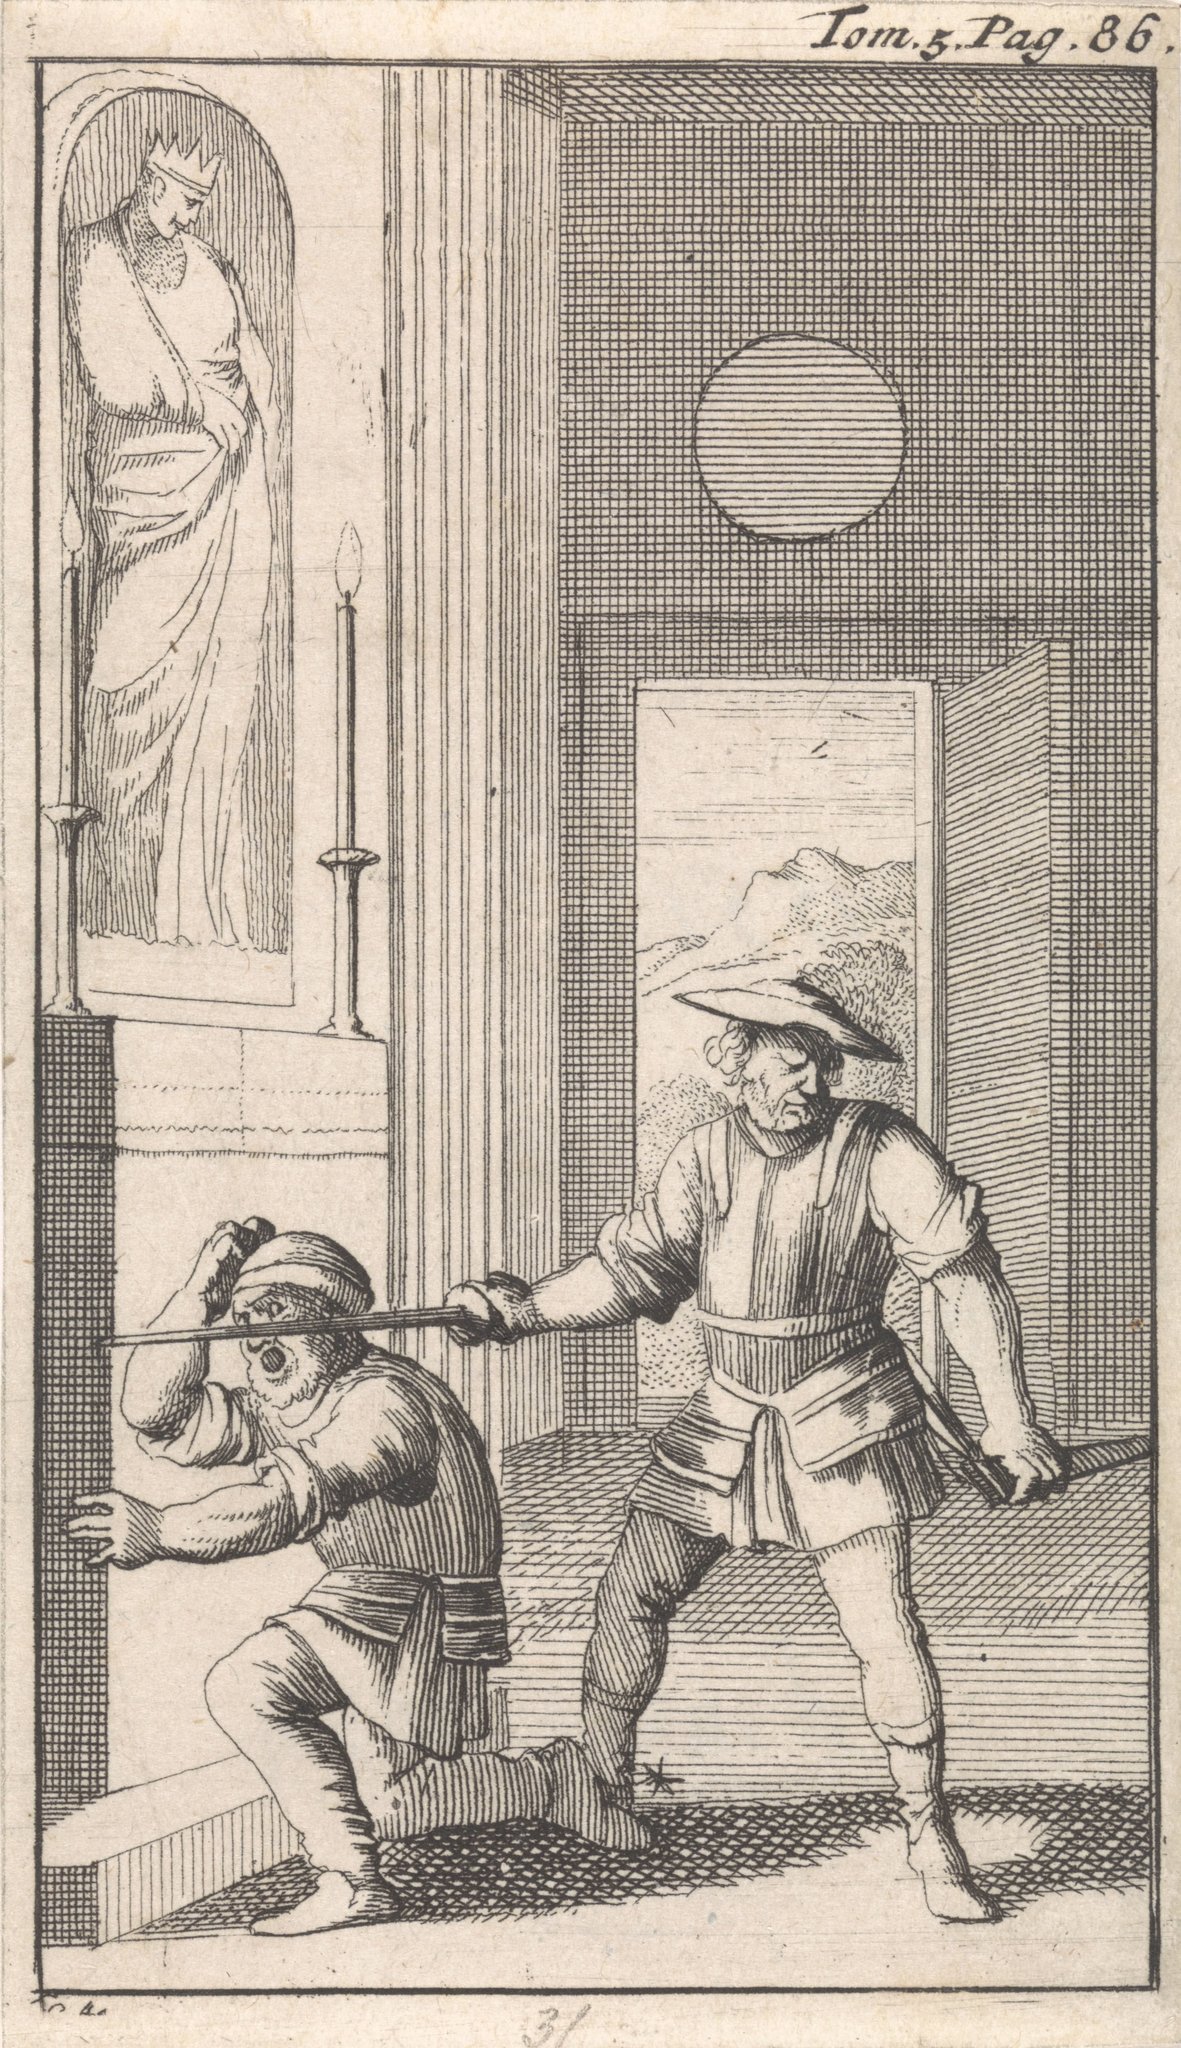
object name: book illustration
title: In een kerk knielt Sancho voor een heiligenbeeld en wordt door zijn meester tot ridder geslagen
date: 1696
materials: paper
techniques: etching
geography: amsterdam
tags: don quixote, sancho panza, becoming a knight, knighting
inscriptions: collector's mark: Lugt 2228, number: ‘31’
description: Illustratie uit: Cervantes y Saavedra, Miguel de. Histoire de l'admirable Don Quixotte de La Manche, 5 delen. Amsterdam: Pieter Mortier, 1696, dl. V.